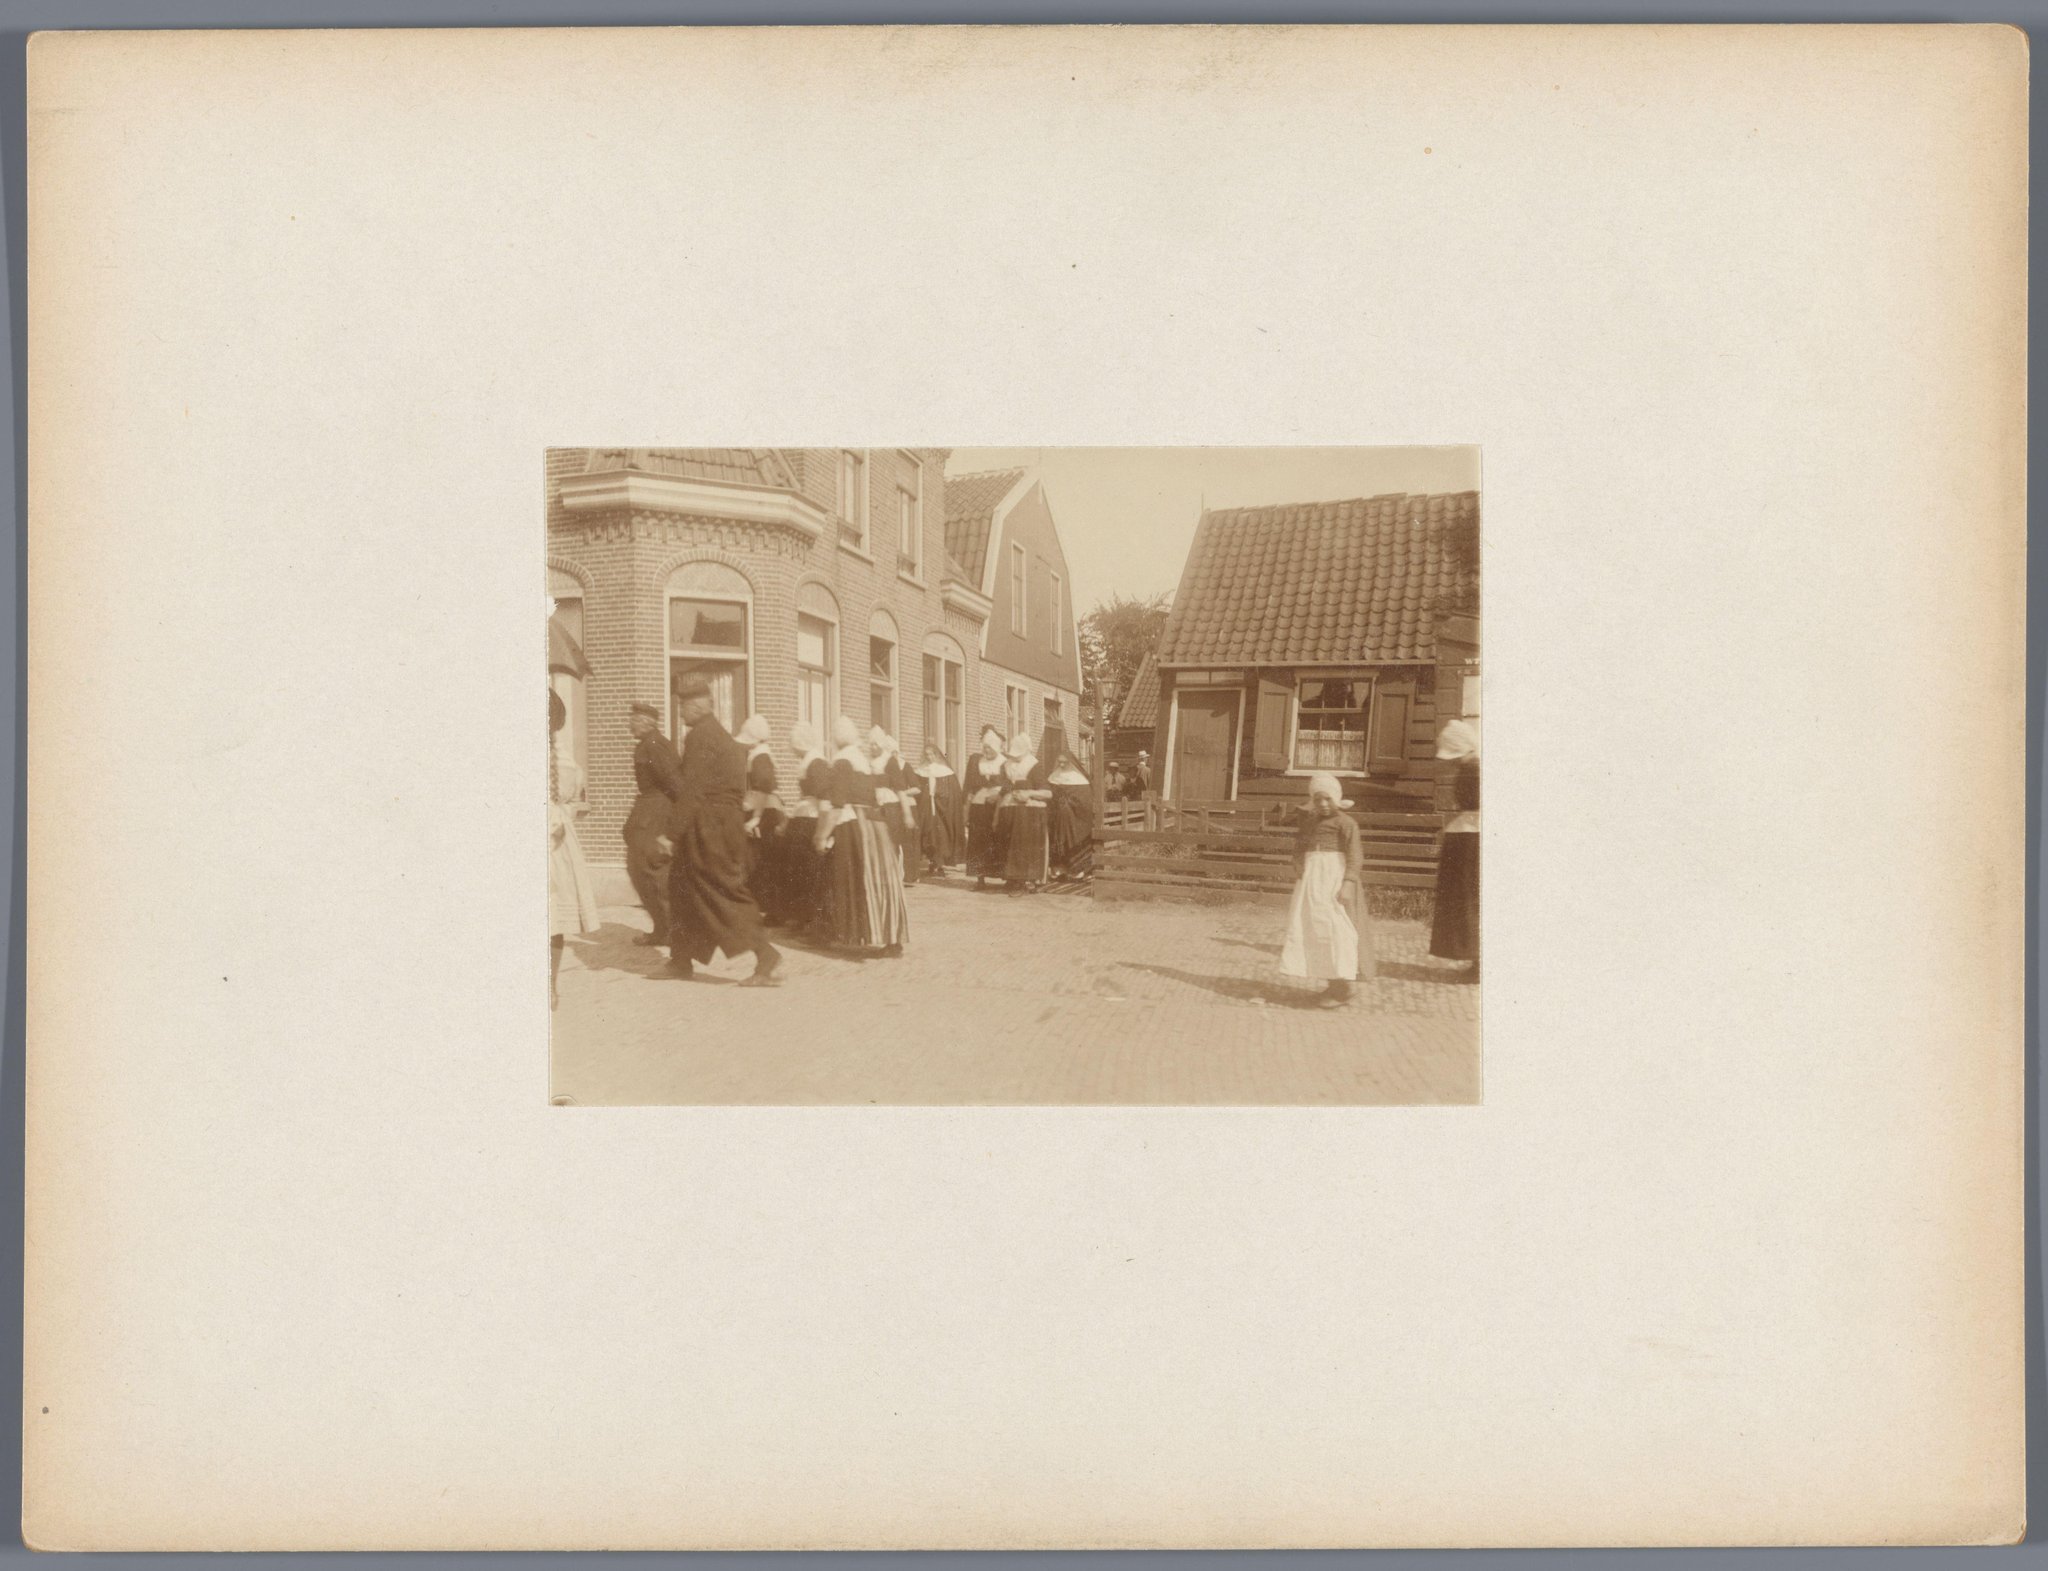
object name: photograph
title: Kerkgangers te Volendam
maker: Anonymous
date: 1907-1910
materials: cardboard, photographic support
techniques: collodion silver print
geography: volendam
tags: going to church, folk costume, regional costume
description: Mannen en vrouwen in klederdracht op in Volendam, mogelijk op weg naar de kerk. Onderdeel van het losbladige fotoalbum met 39 foto's van een reis door Nederland, ca. 1907-1910.